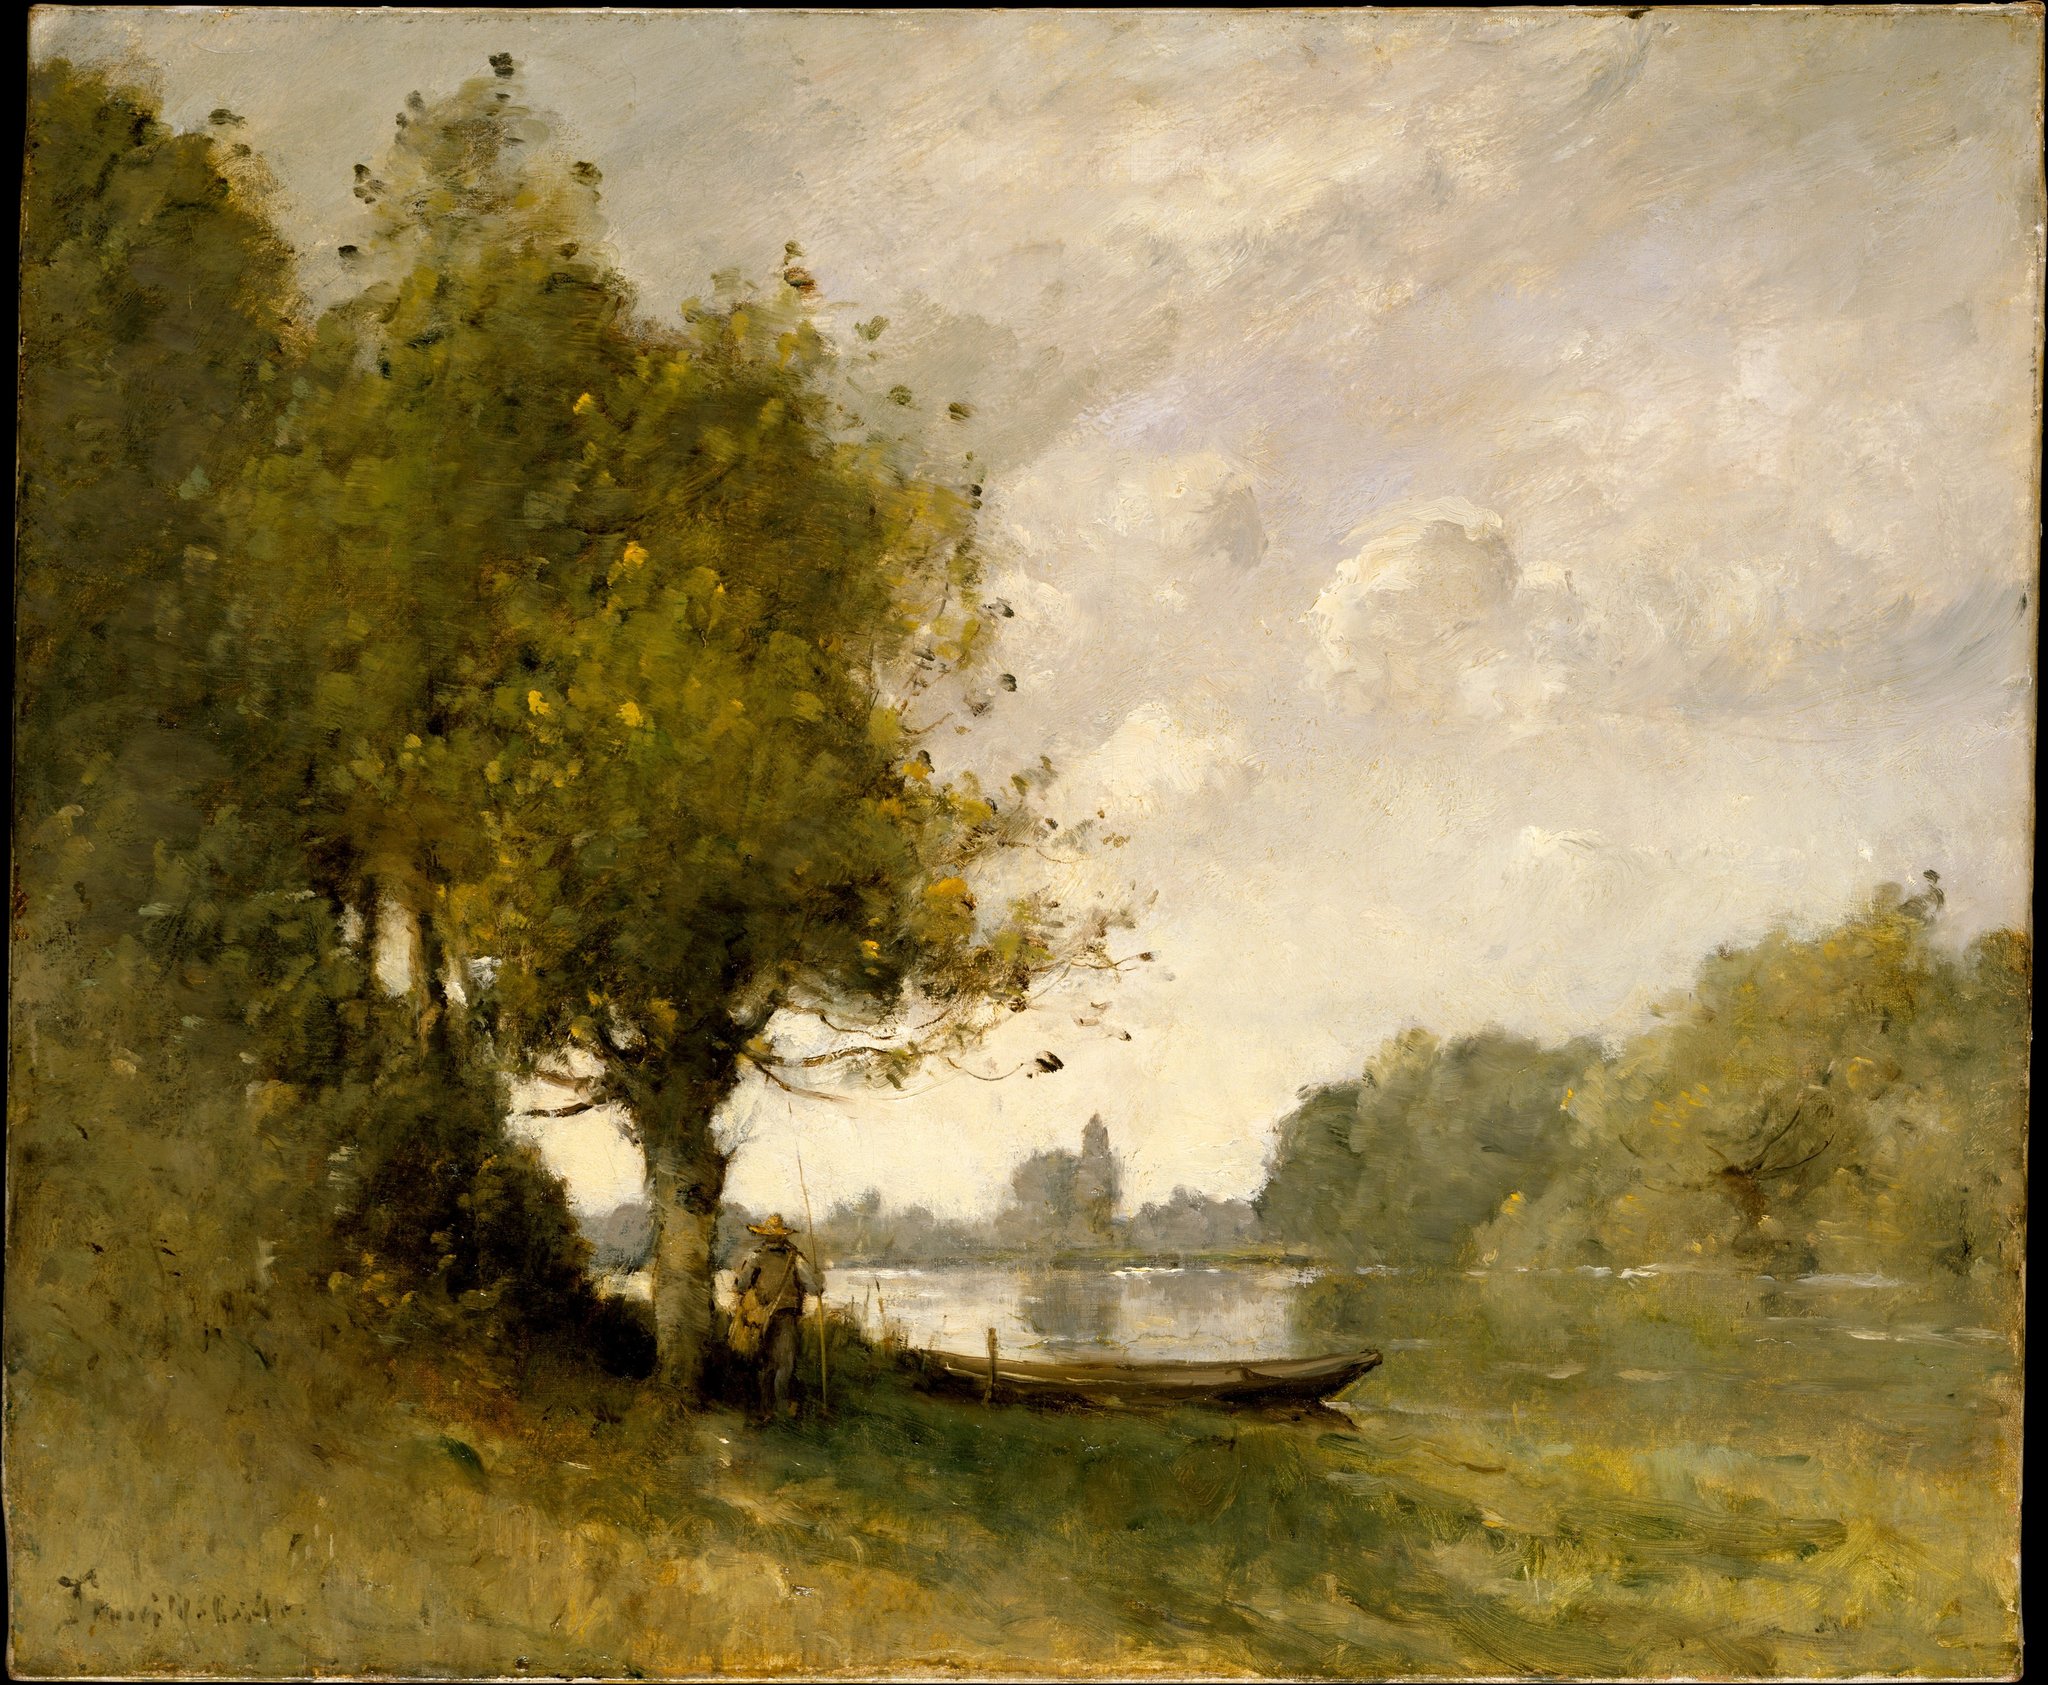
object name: painting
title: A Pond near Nangis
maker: paul-désiré trouillebert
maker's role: artist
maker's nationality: french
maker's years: 1829-1900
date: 1880-1895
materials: canvas, oil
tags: landscapes,boats